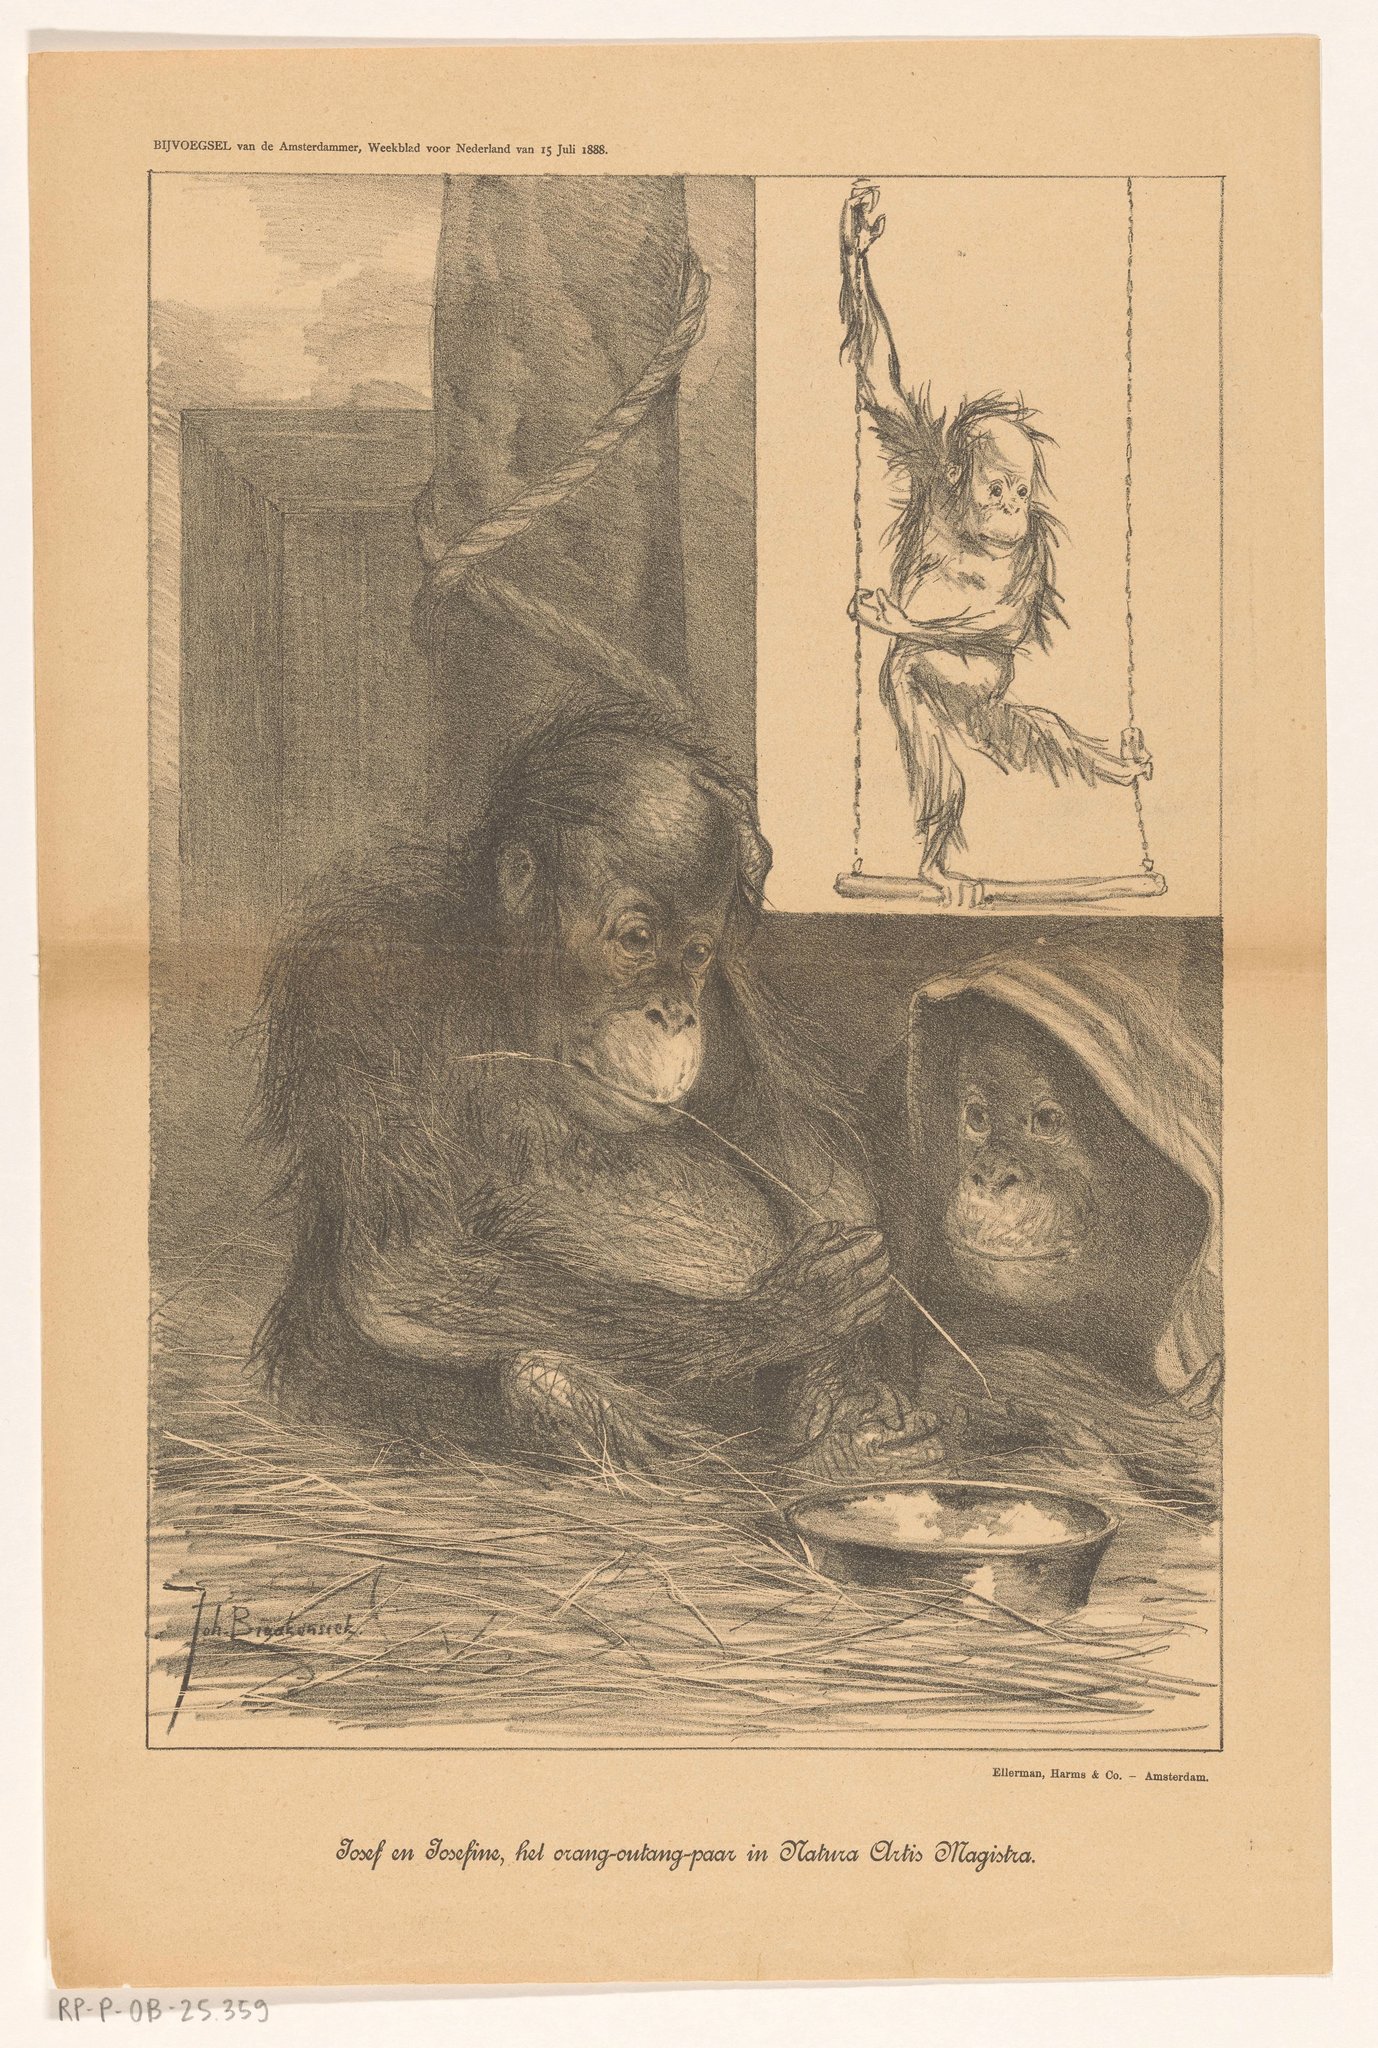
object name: print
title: Josef en Josefine, het orang-outang-paar in Natura Artis Magistra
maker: johan braakensiek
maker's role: draughtsman, print maker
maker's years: 1858-1940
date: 1888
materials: paper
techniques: lithograph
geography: amsterdam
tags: monkeys, apes, swing, zoological garden, zoo, seen as place where non-domestic animals are kept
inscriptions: collector's mark: Lugt 2228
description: De orang-oetans Josef en Josefine, zittend op het hooi in hun verblijf in Artis. Rechtsboven een jonge orang-oetan staand op een schommel.